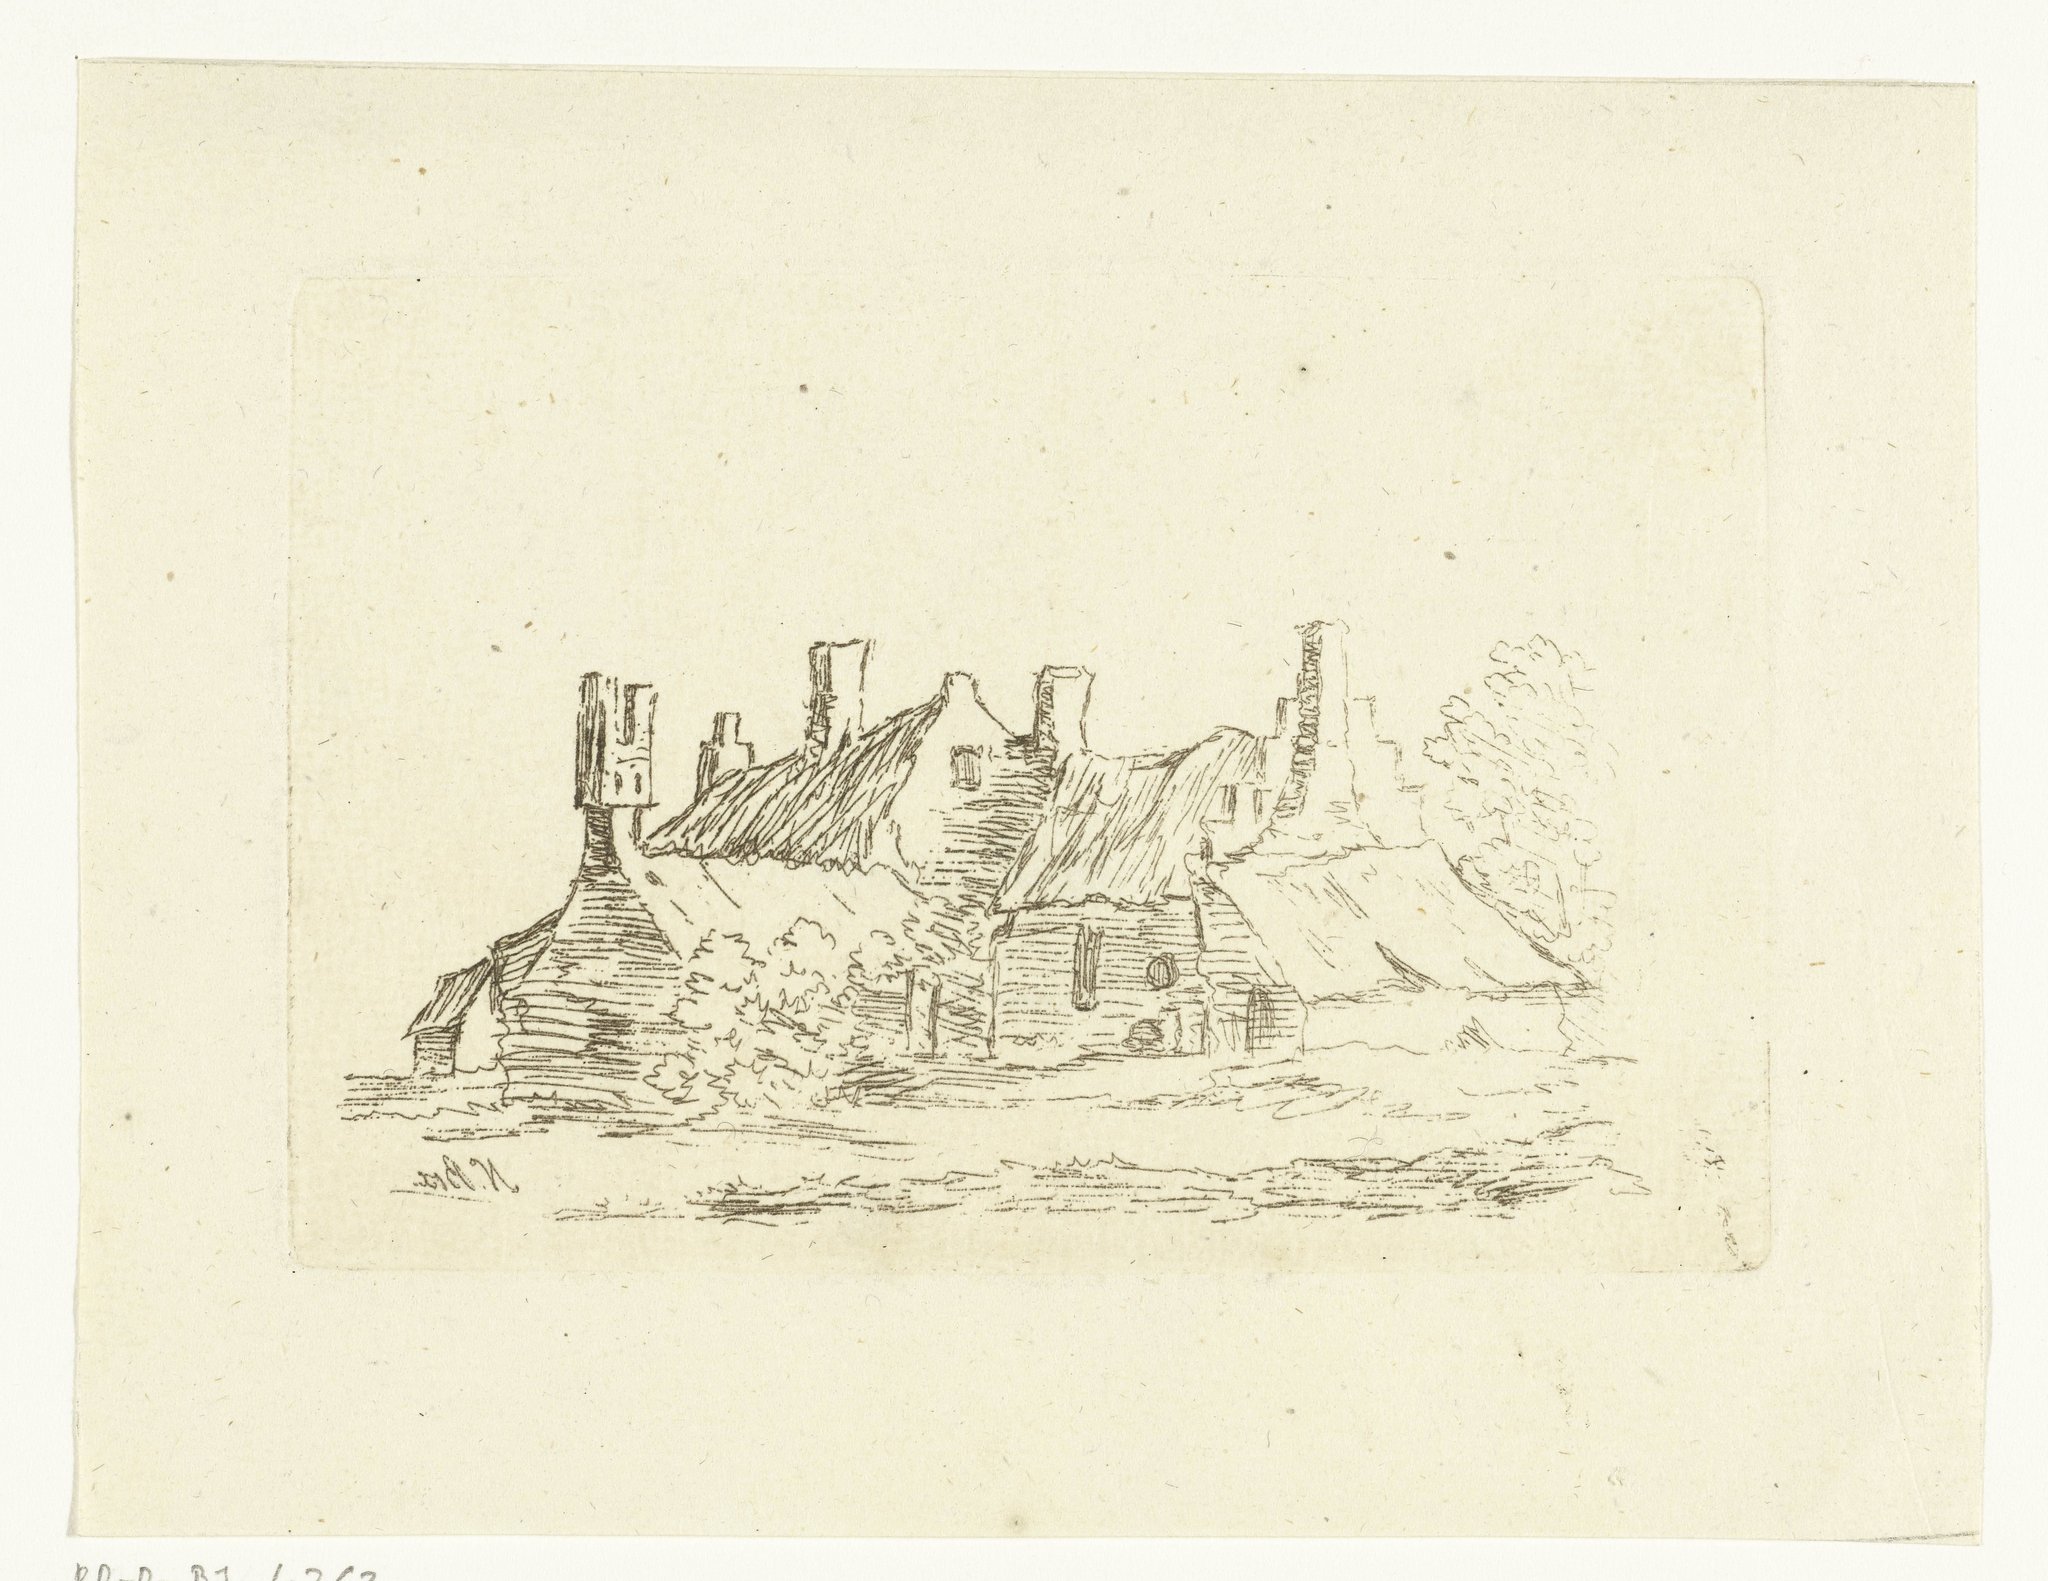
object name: print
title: Boerderij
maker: nicolaas box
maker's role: draughtsman, print maker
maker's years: 1785-1864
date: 1800-1864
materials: paper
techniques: etching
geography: netherlands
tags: farm or solitary house in landscape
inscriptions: collector's mark: Lugt 2228